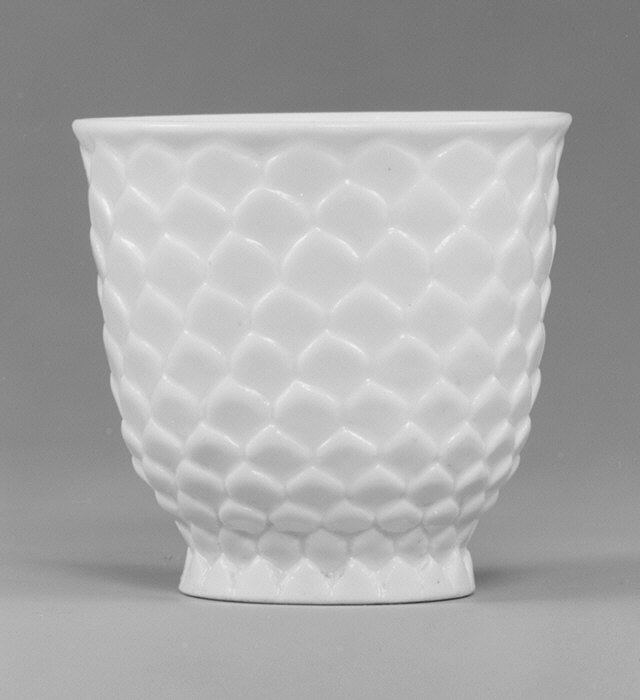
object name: cup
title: Cup (one of a pair)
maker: saint-cloud factory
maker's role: factory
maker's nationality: french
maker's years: 1693-1766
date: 1725-1740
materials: soft paste porcelain